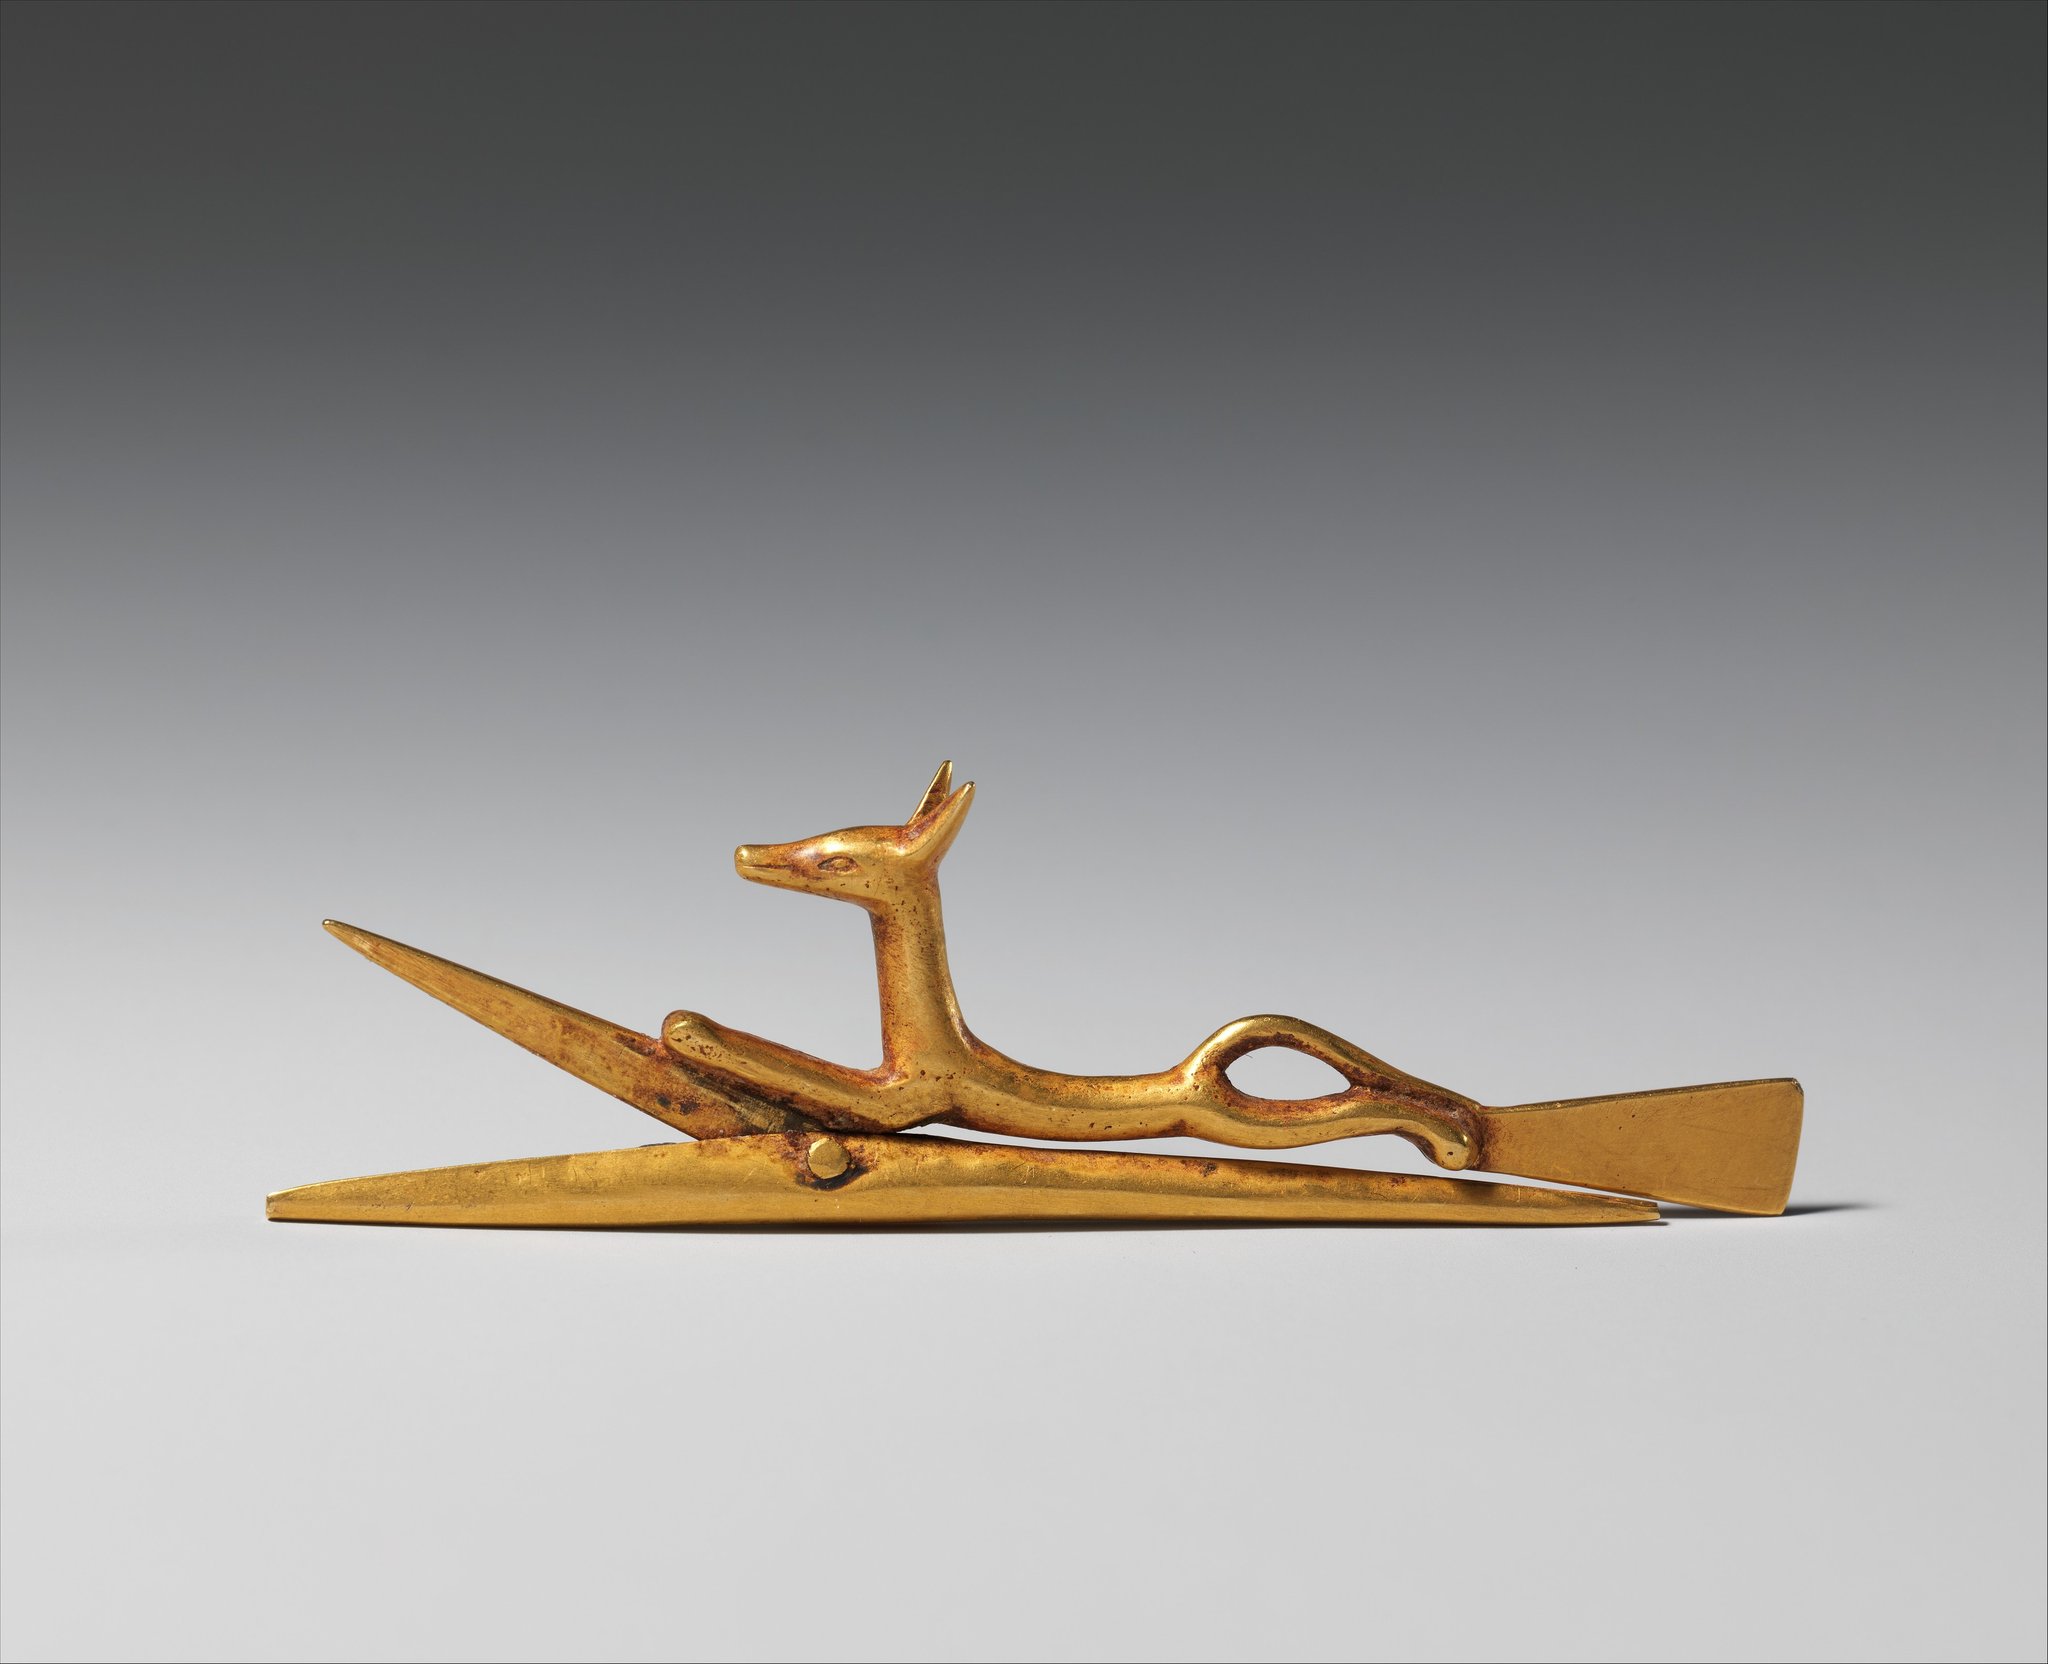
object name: tweezer razor, razor, tweezer, hair curler, knife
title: Tweezer-Razor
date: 1560-1479 BCE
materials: gold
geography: egypt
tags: jackals